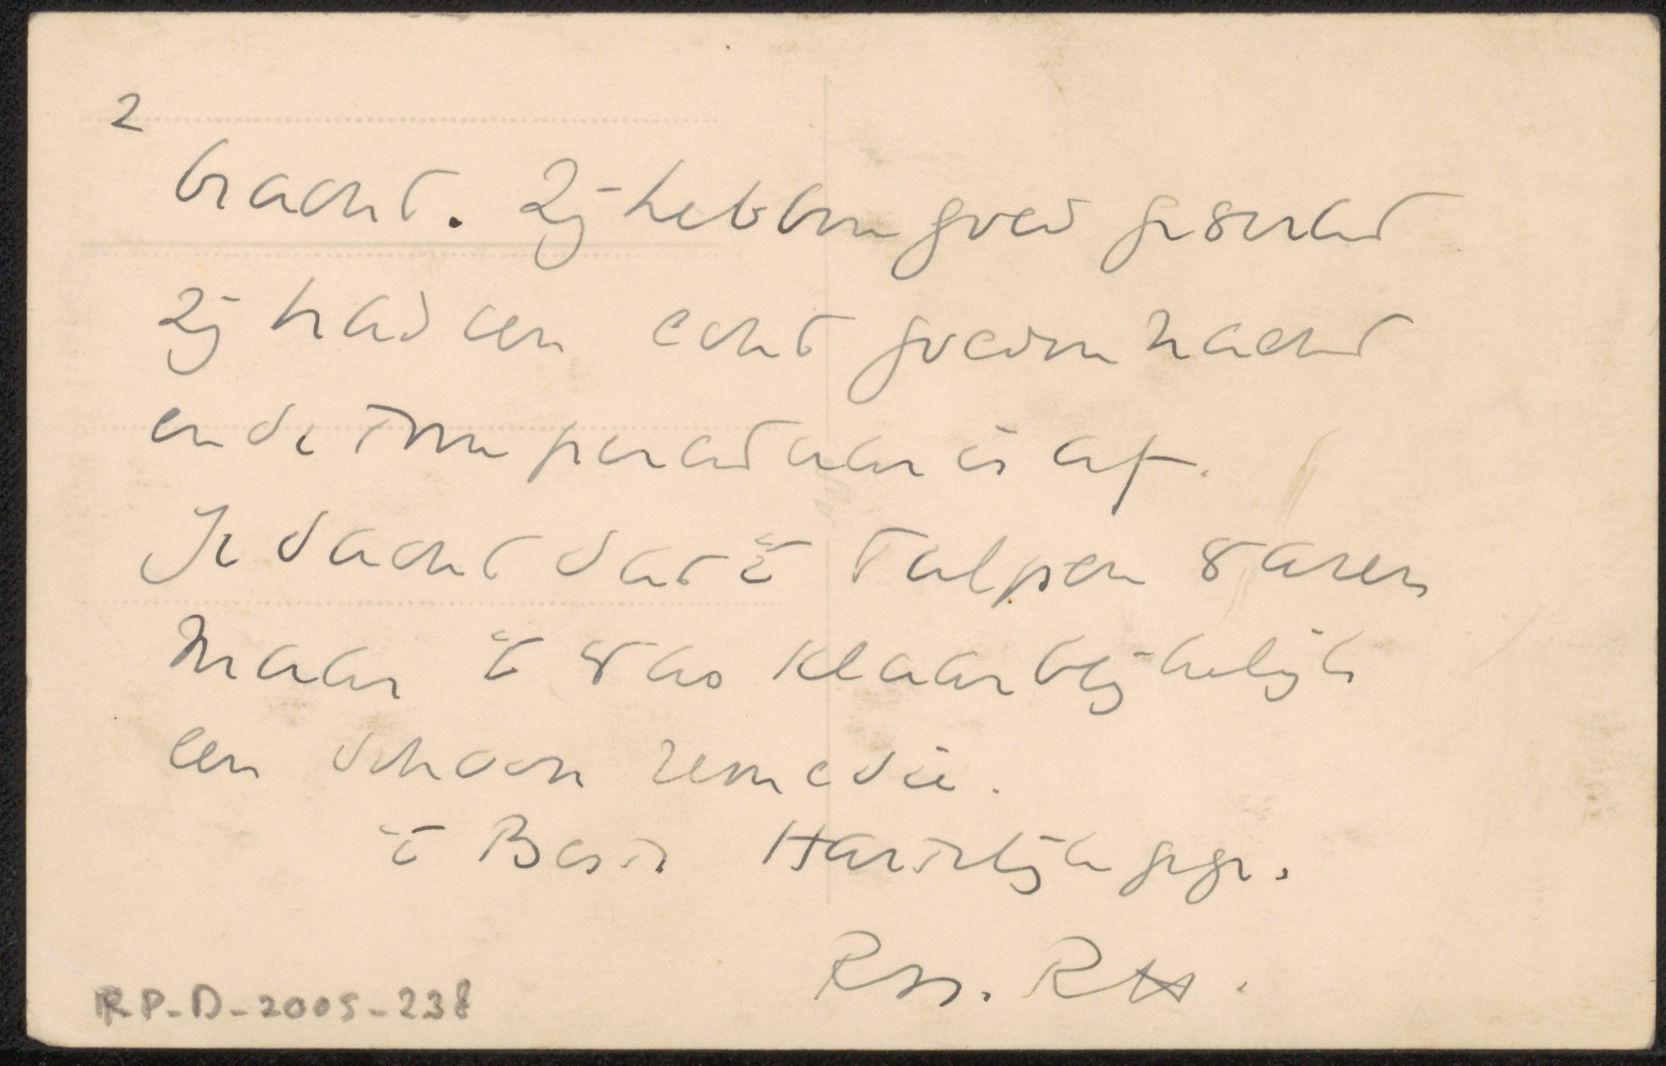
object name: ansichtkaart, prentbriefkaart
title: Prentbriefkaart aan Joop Sjollema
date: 1910-1938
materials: cardboard, ink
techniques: pen, printing, writing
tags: print maker, draughtsman, joop sjollema